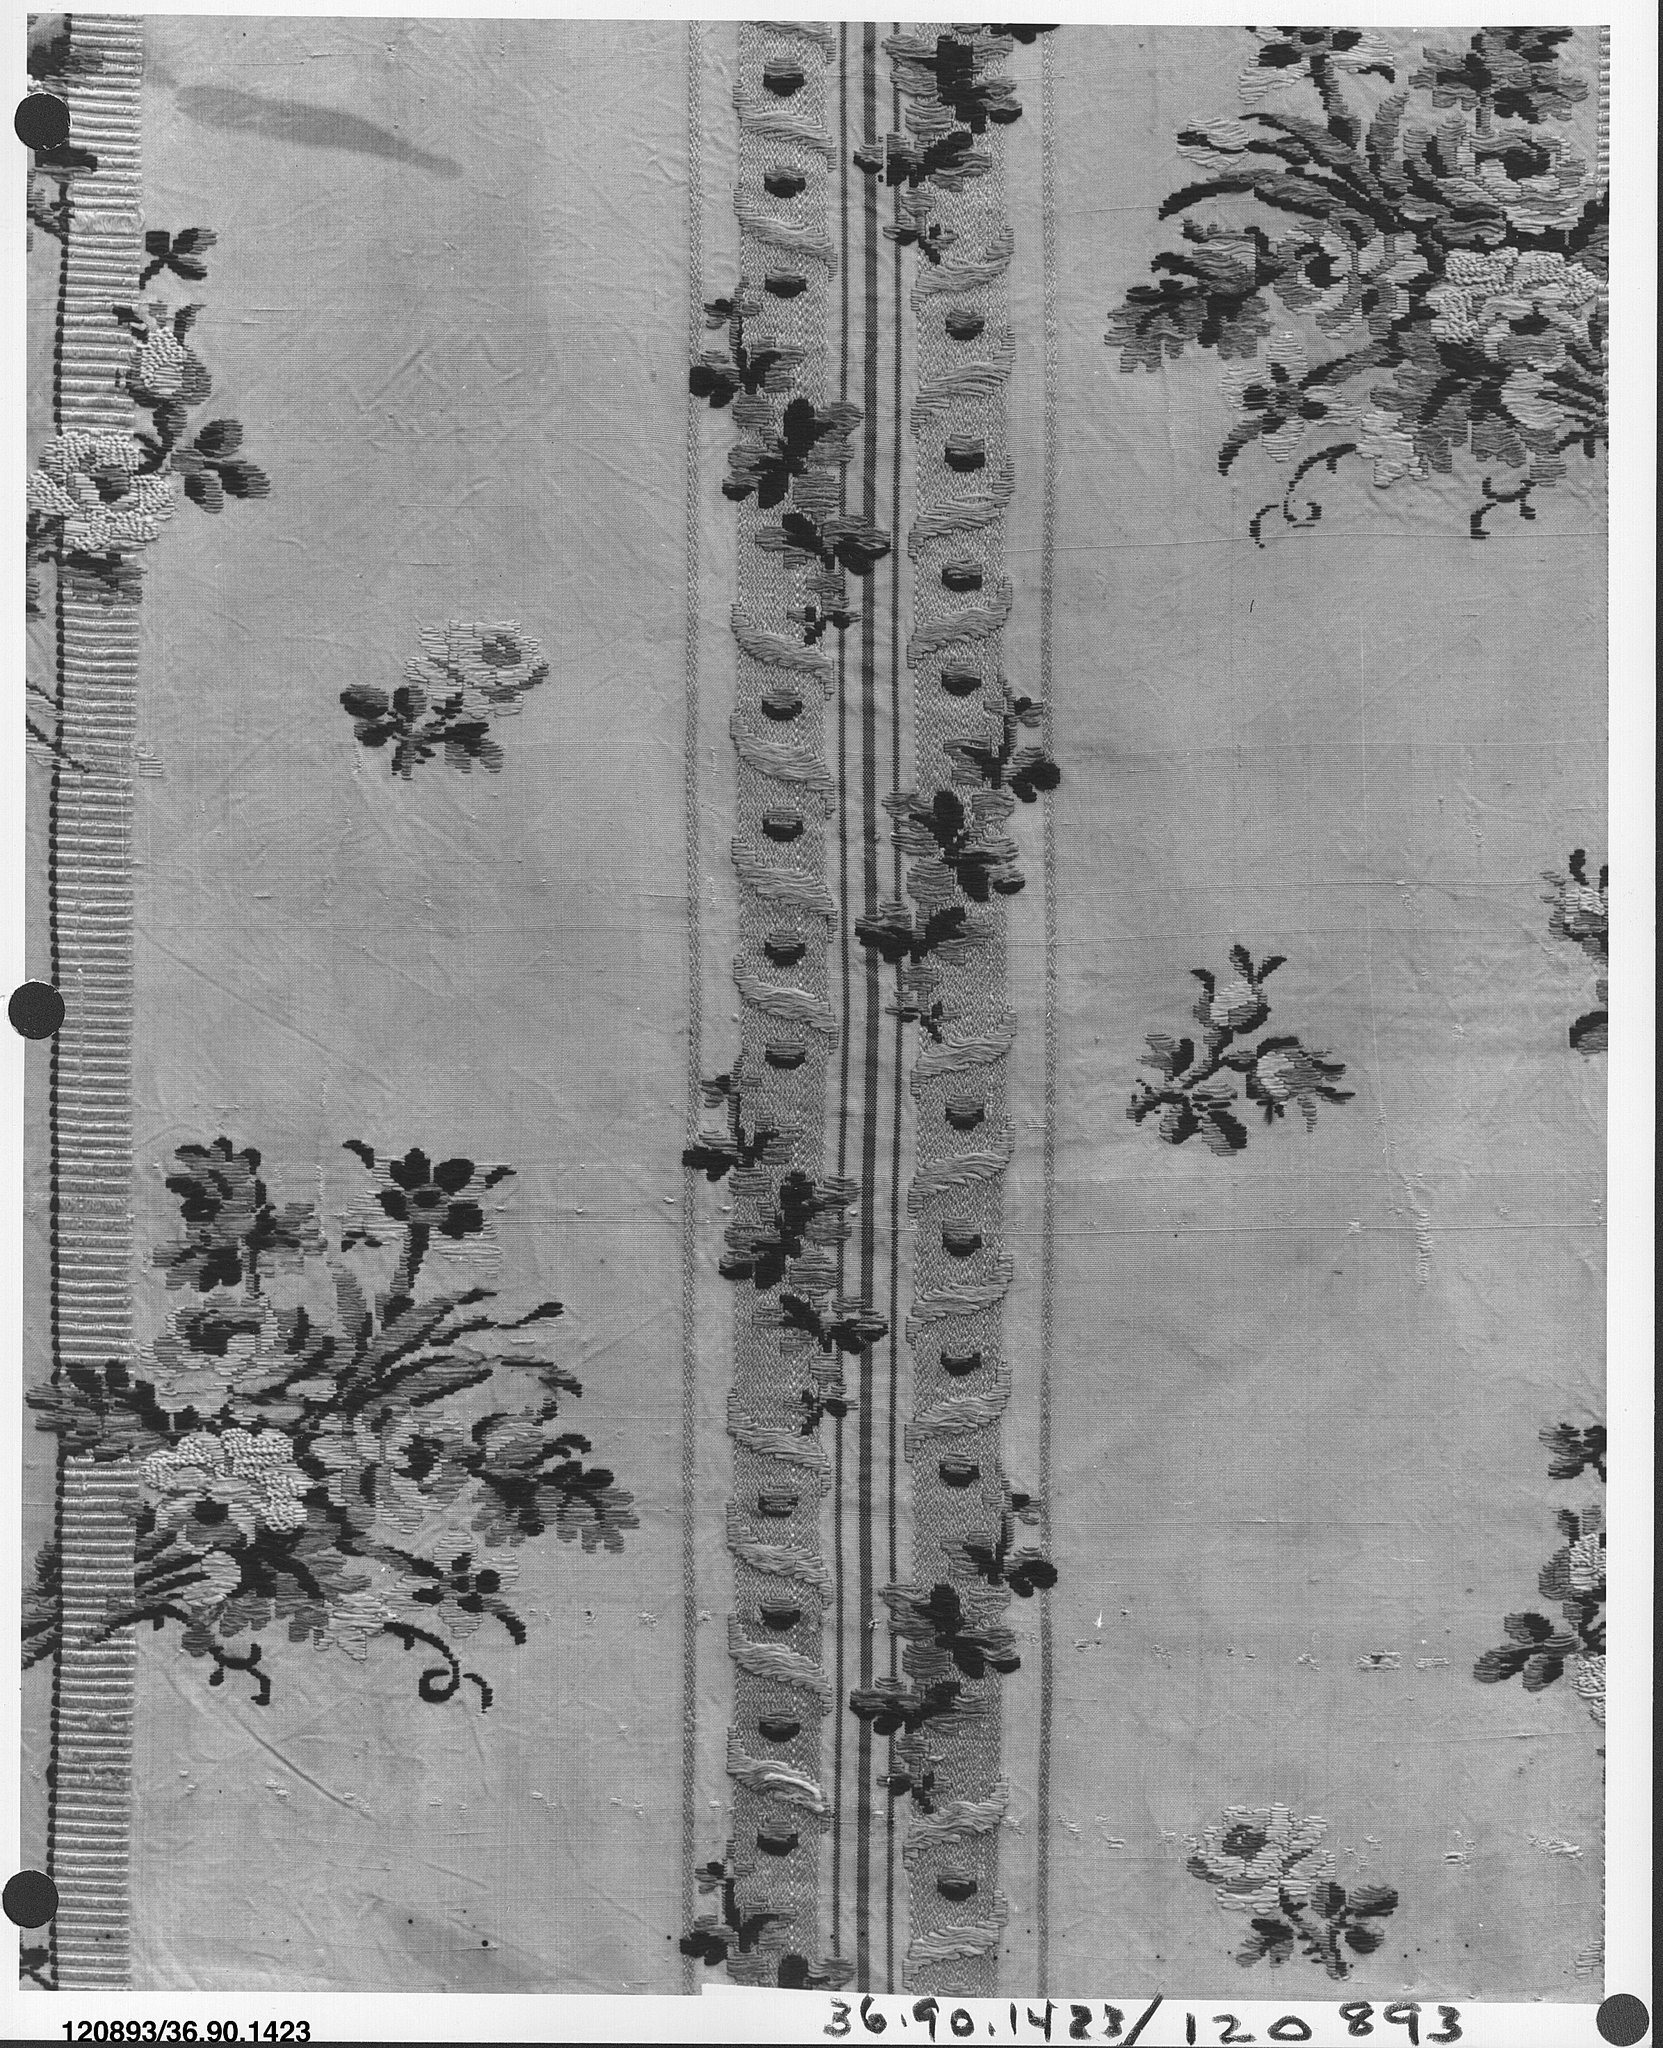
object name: piece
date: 1701-1800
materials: silk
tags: flowers,leaves